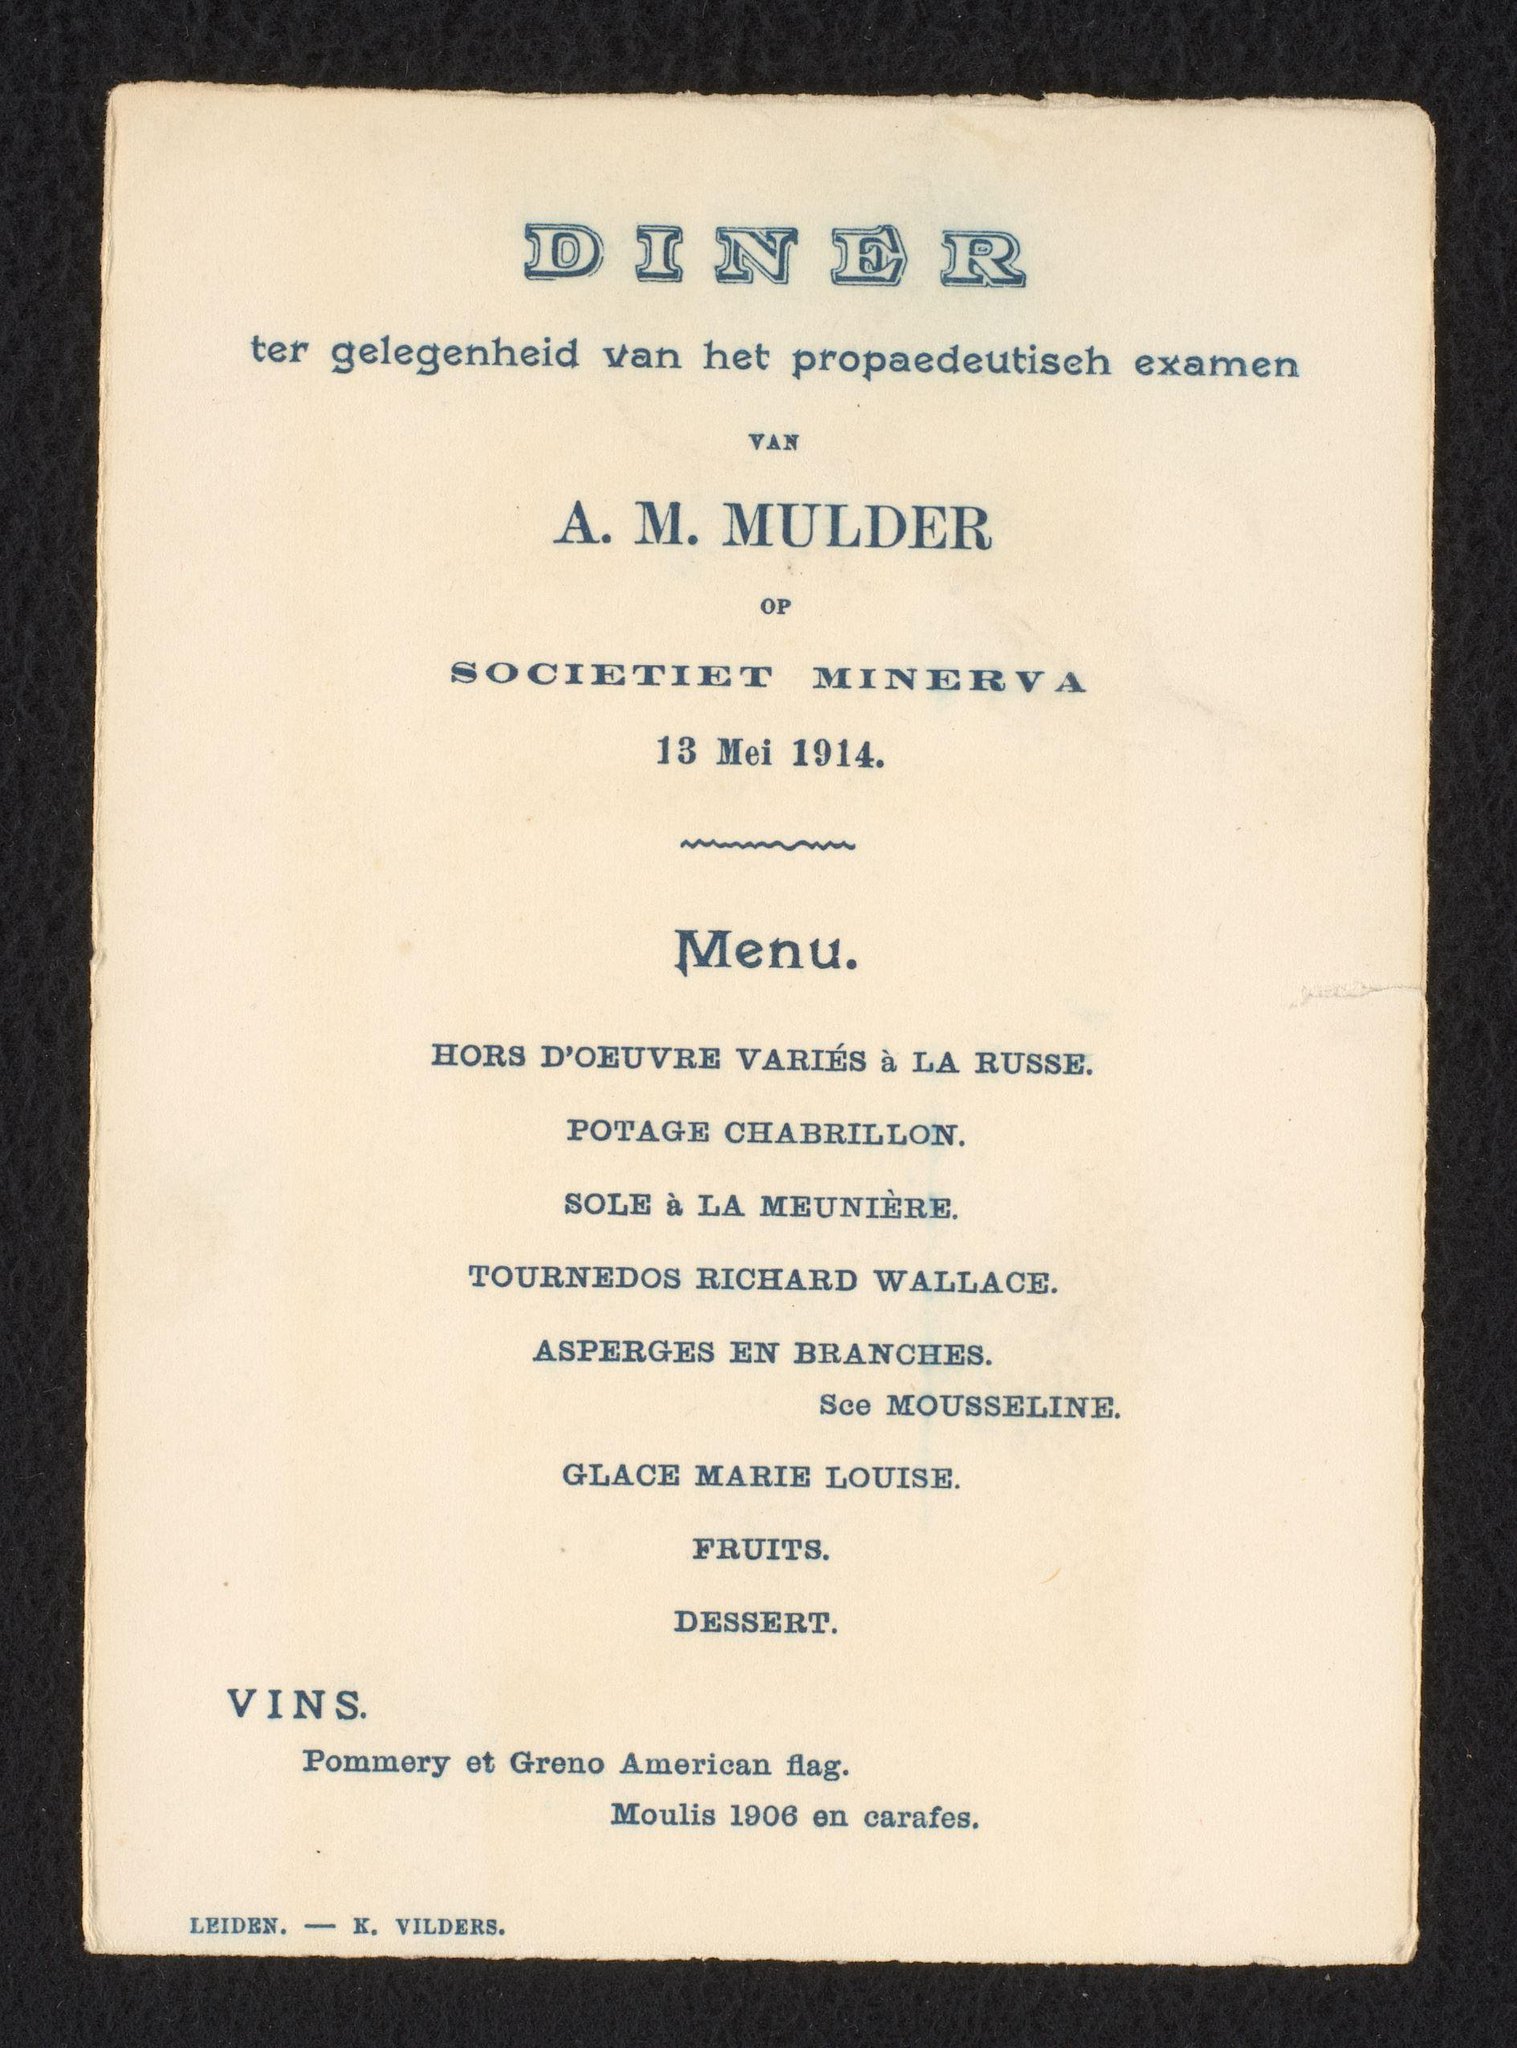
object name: menu, menukaart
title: Menukaart voor het diner ter ere van het behalen van de propedeuse door A.M. Mulder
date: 1914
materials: paper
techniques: letterpress printing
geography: leiden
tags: leiden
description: Bij gebrek aan gegevens over de vervaardiger is voor de bepaling van de rechten van dit object gebruik gemaakt van de vervaardigingsdatum.